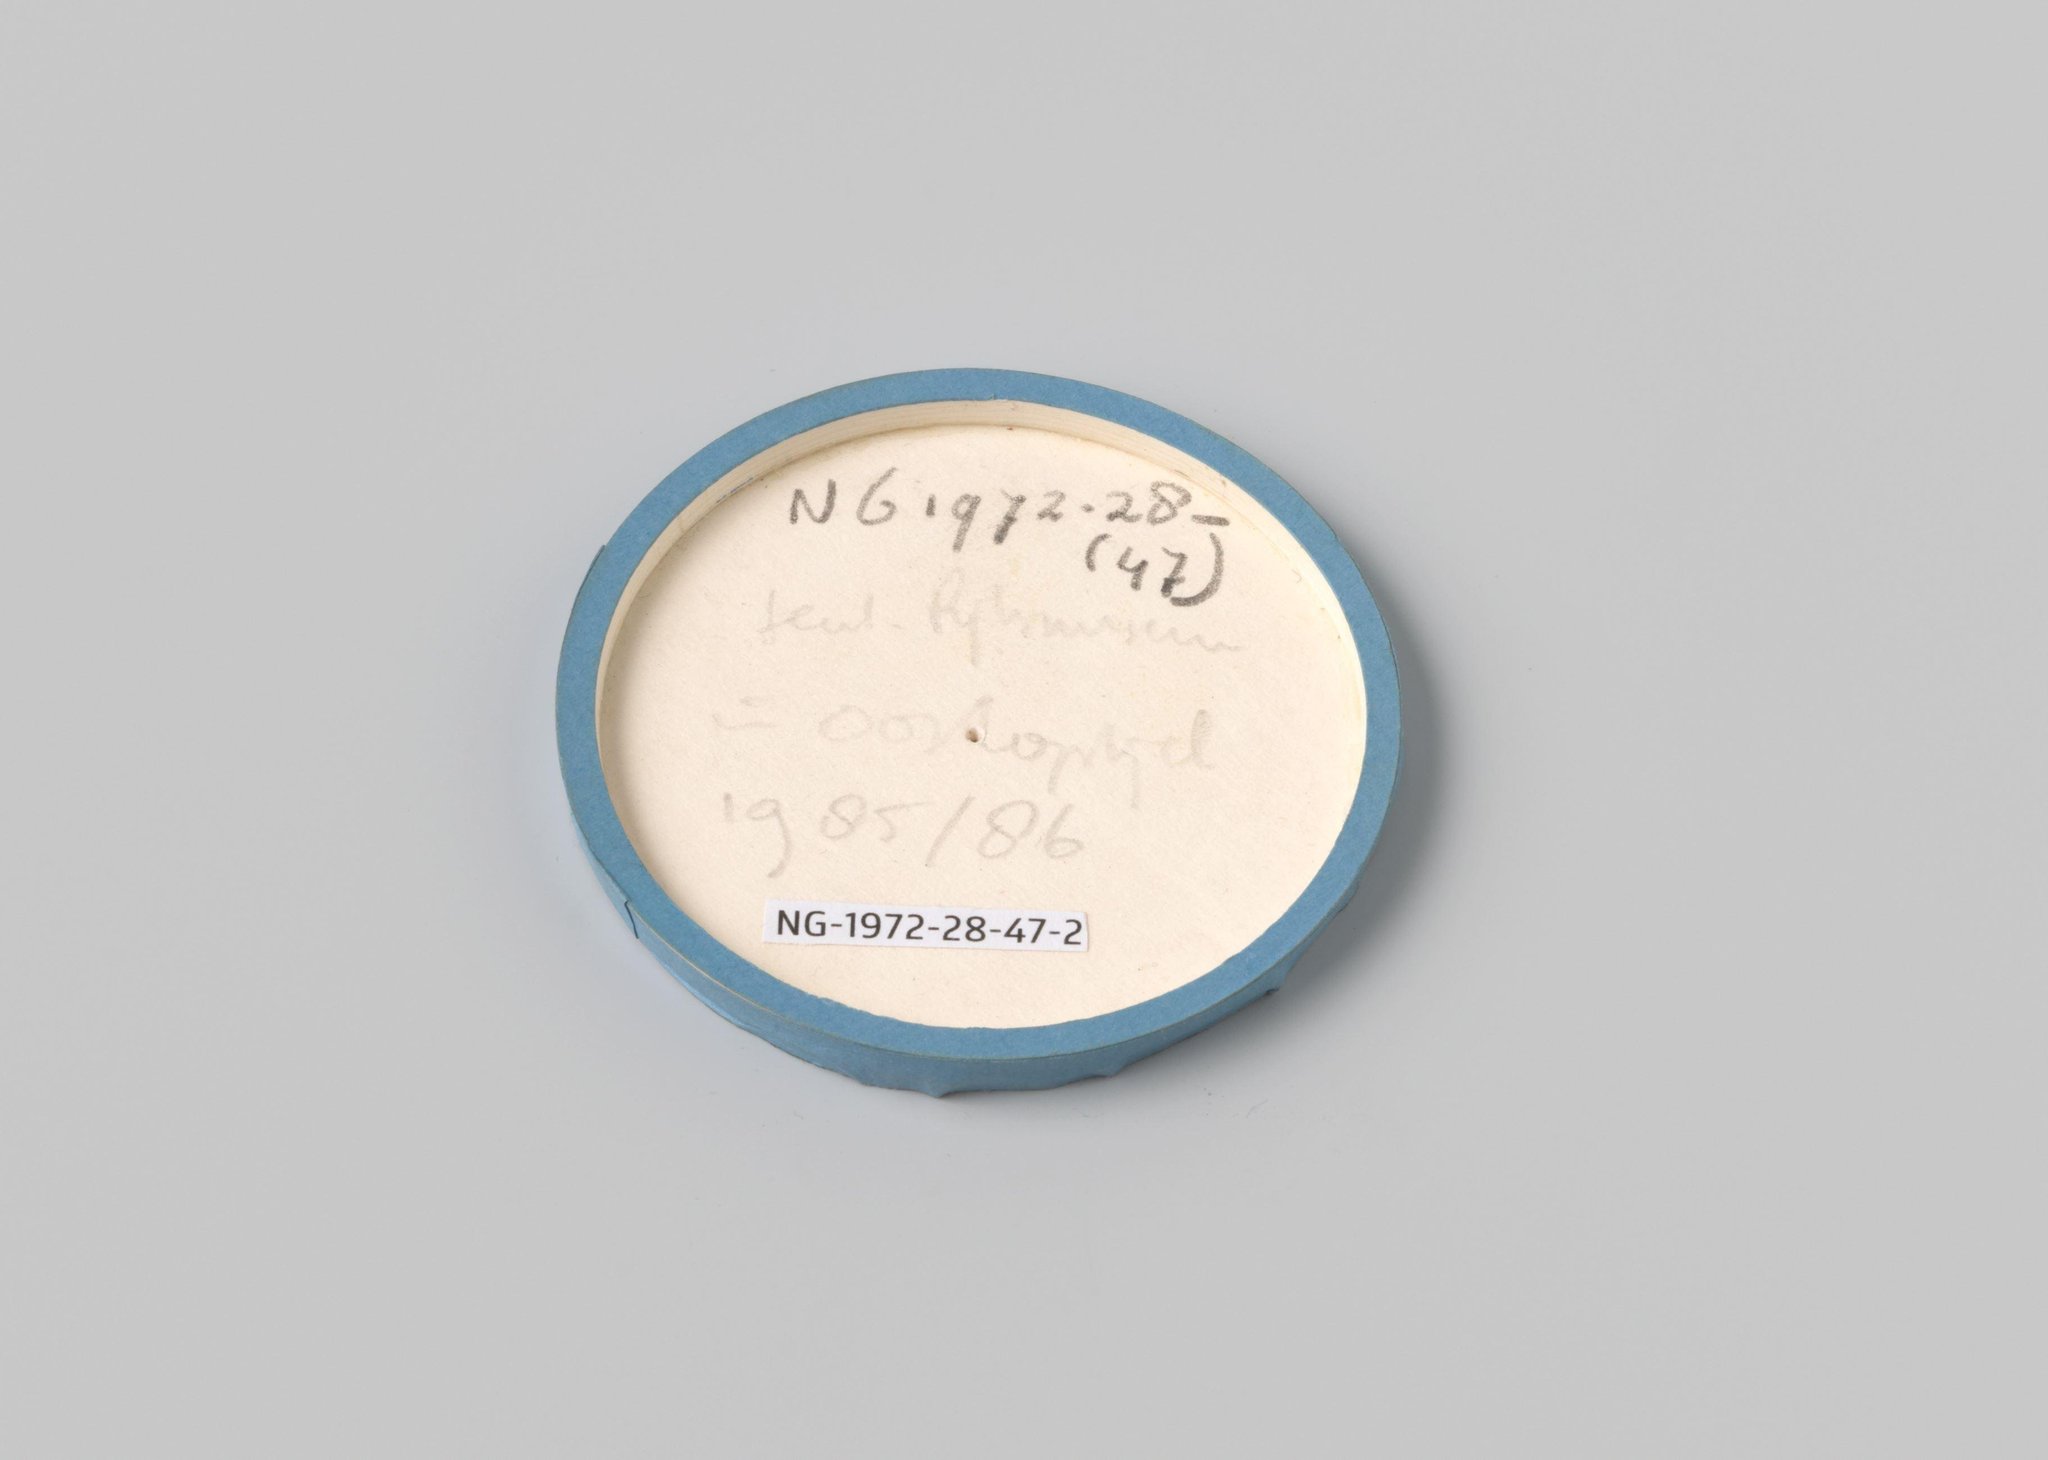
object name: box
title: Medal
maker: hildo krop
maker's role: draughtsman, print maker, sculptor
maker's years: 1884-1970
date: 1945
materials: cardboard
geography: utrecht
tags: print maker, draughtsman, jan petrus ponstijn, sculptor, gerrit jan van der veen, amsterdam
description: Rond kartonnen doosje, deksel ontbreekt.